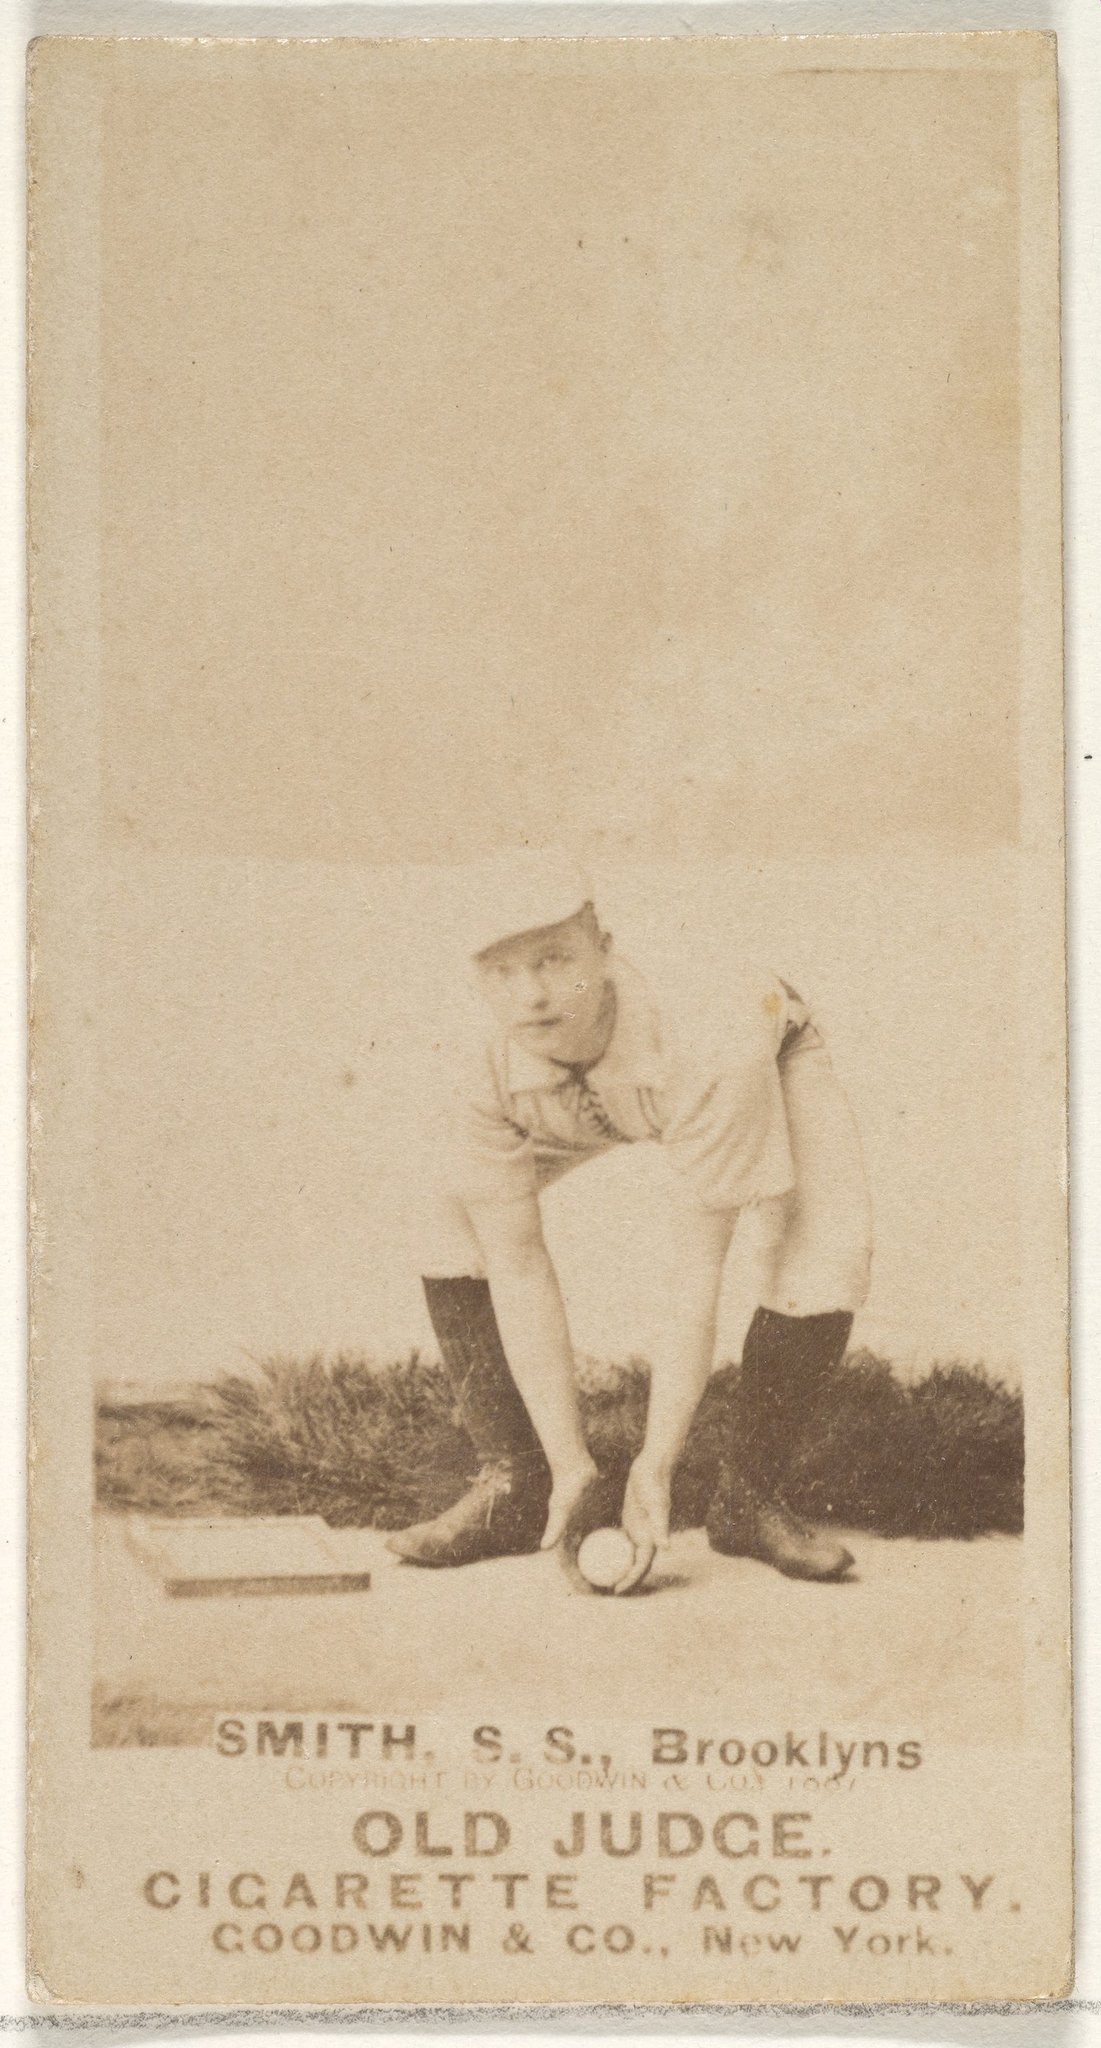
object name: baseball card, photograph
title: G. Smith, Shortstop, Brooklyn Bridegrooms, from the Old Judge series (N172) for Old Judge Cigarettes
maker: goodwin & company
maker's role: publisher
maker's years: 1850-1950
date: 1888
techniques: albumen silver print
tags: men,portraits,baseball,athletes